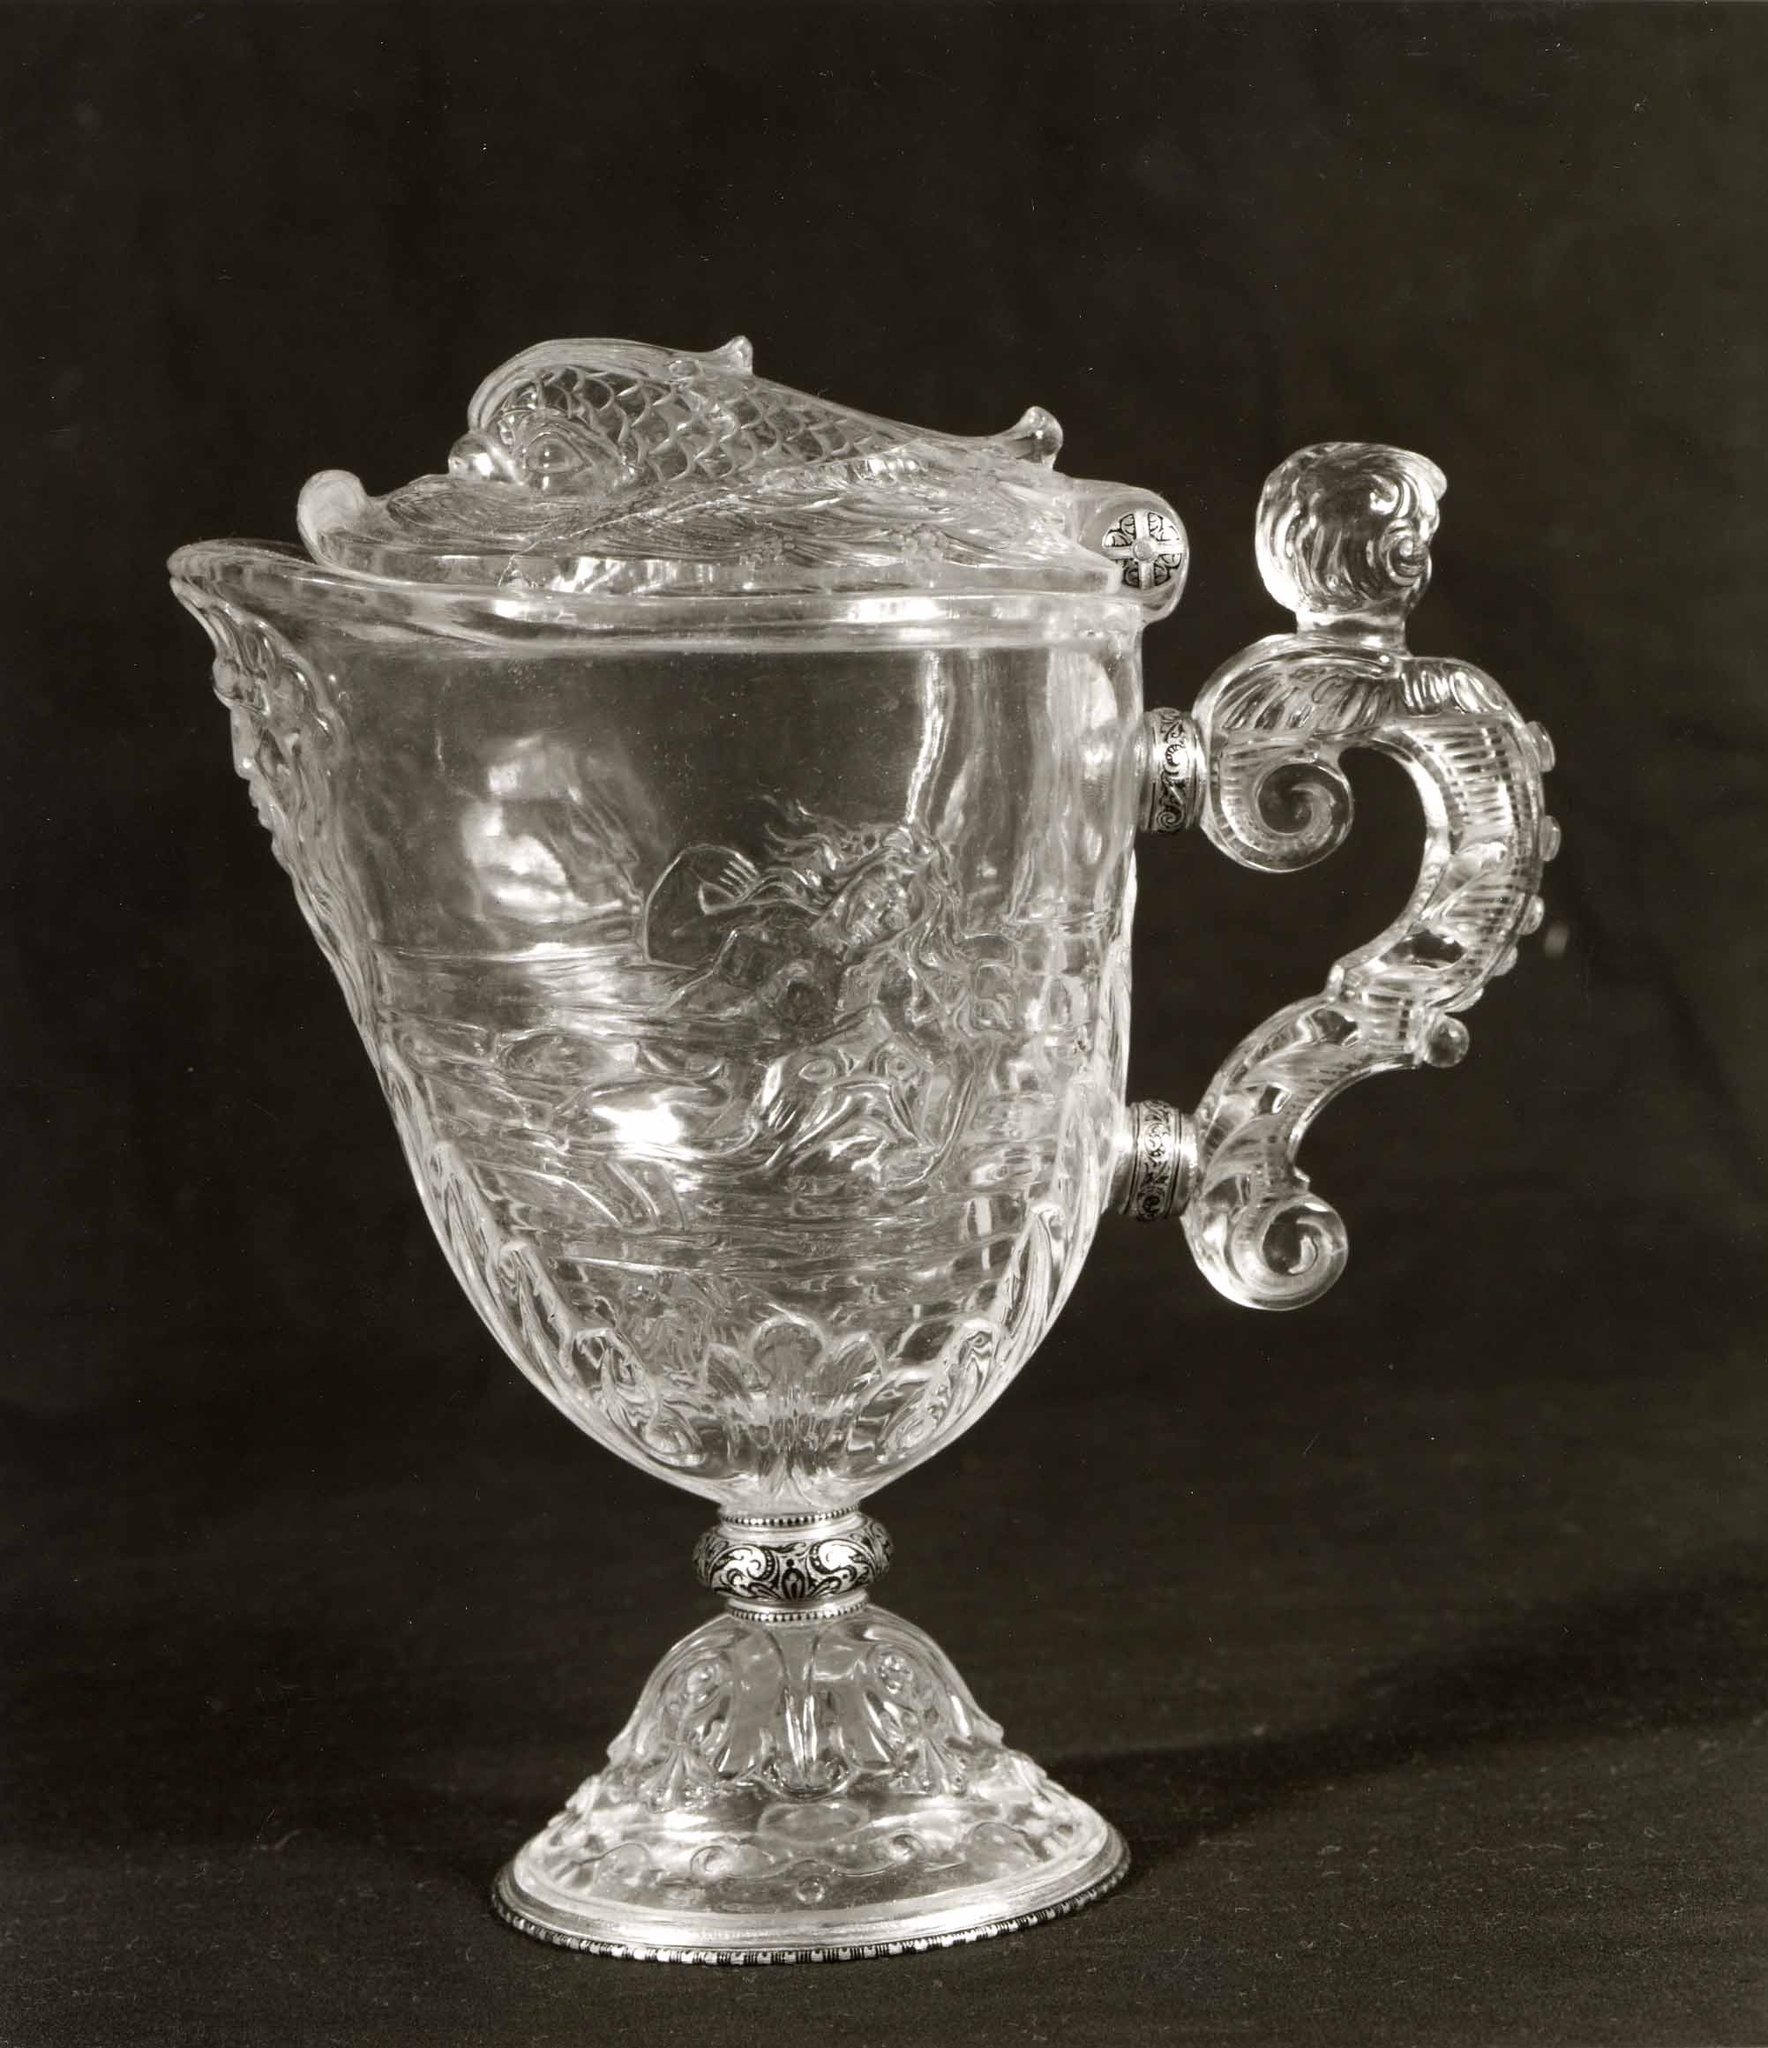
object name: ewer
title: Ewer: Neptune and Amphitrite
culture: german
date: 1859-1907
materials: gold, quartz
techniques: cutting, enamel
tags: neptune